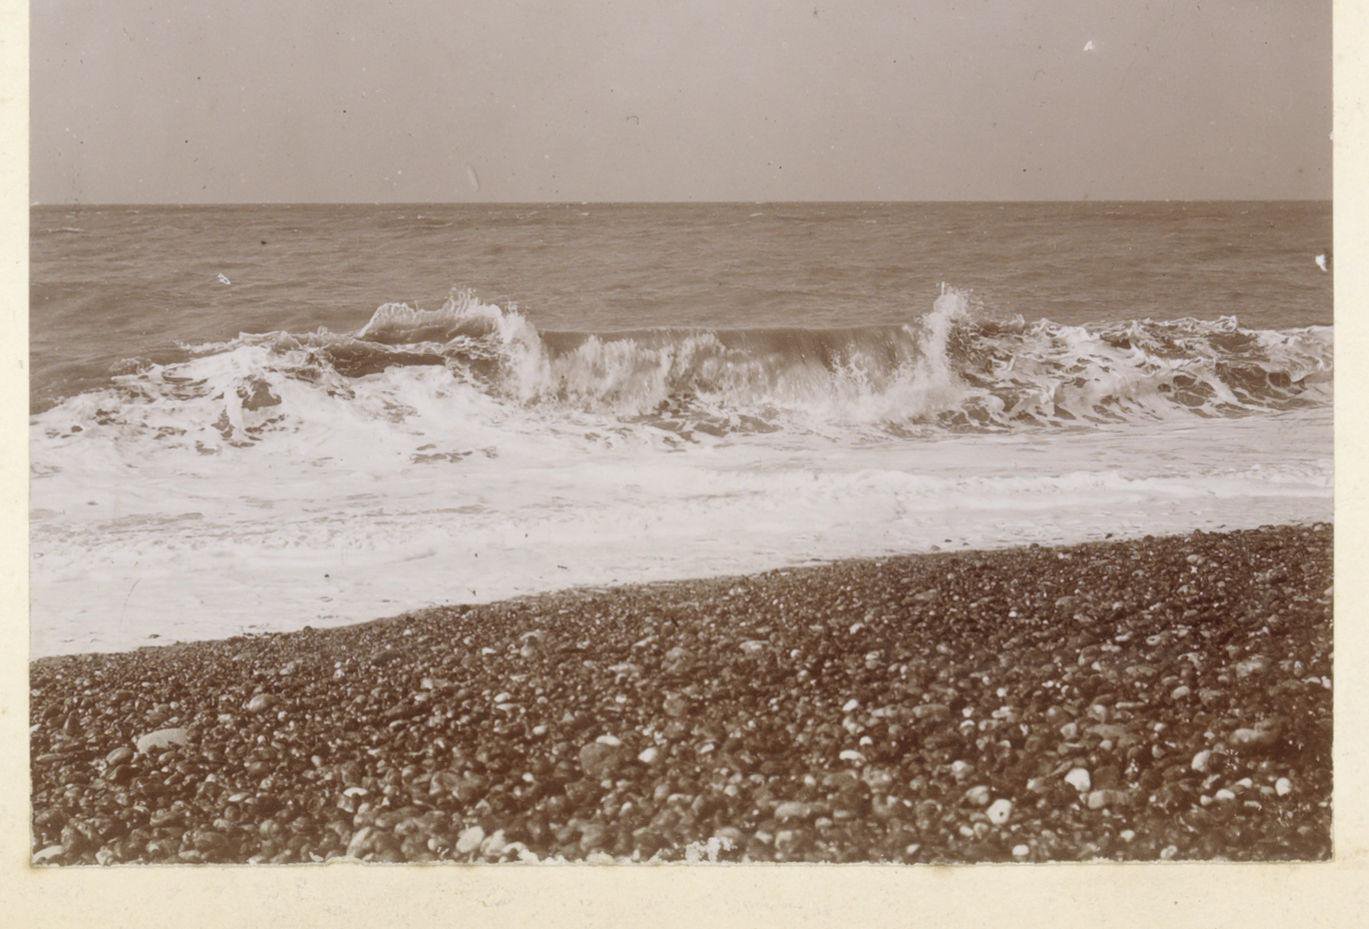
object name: photograph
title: Golf in de branding, vermoedelijk in Zuid-Frankrijk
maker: Anonymous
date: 1900-1910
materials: paper, photographic support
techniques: daylight paper print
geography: southern france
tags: tidal wave, surf, breakers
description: Onderdeel van Fotoalbum van een Franse amateurfotograaf met opnames van een familie, distilleerderij Delizy & Doistau Fils, het leger en bezienswaardigheden in Frankrijk.